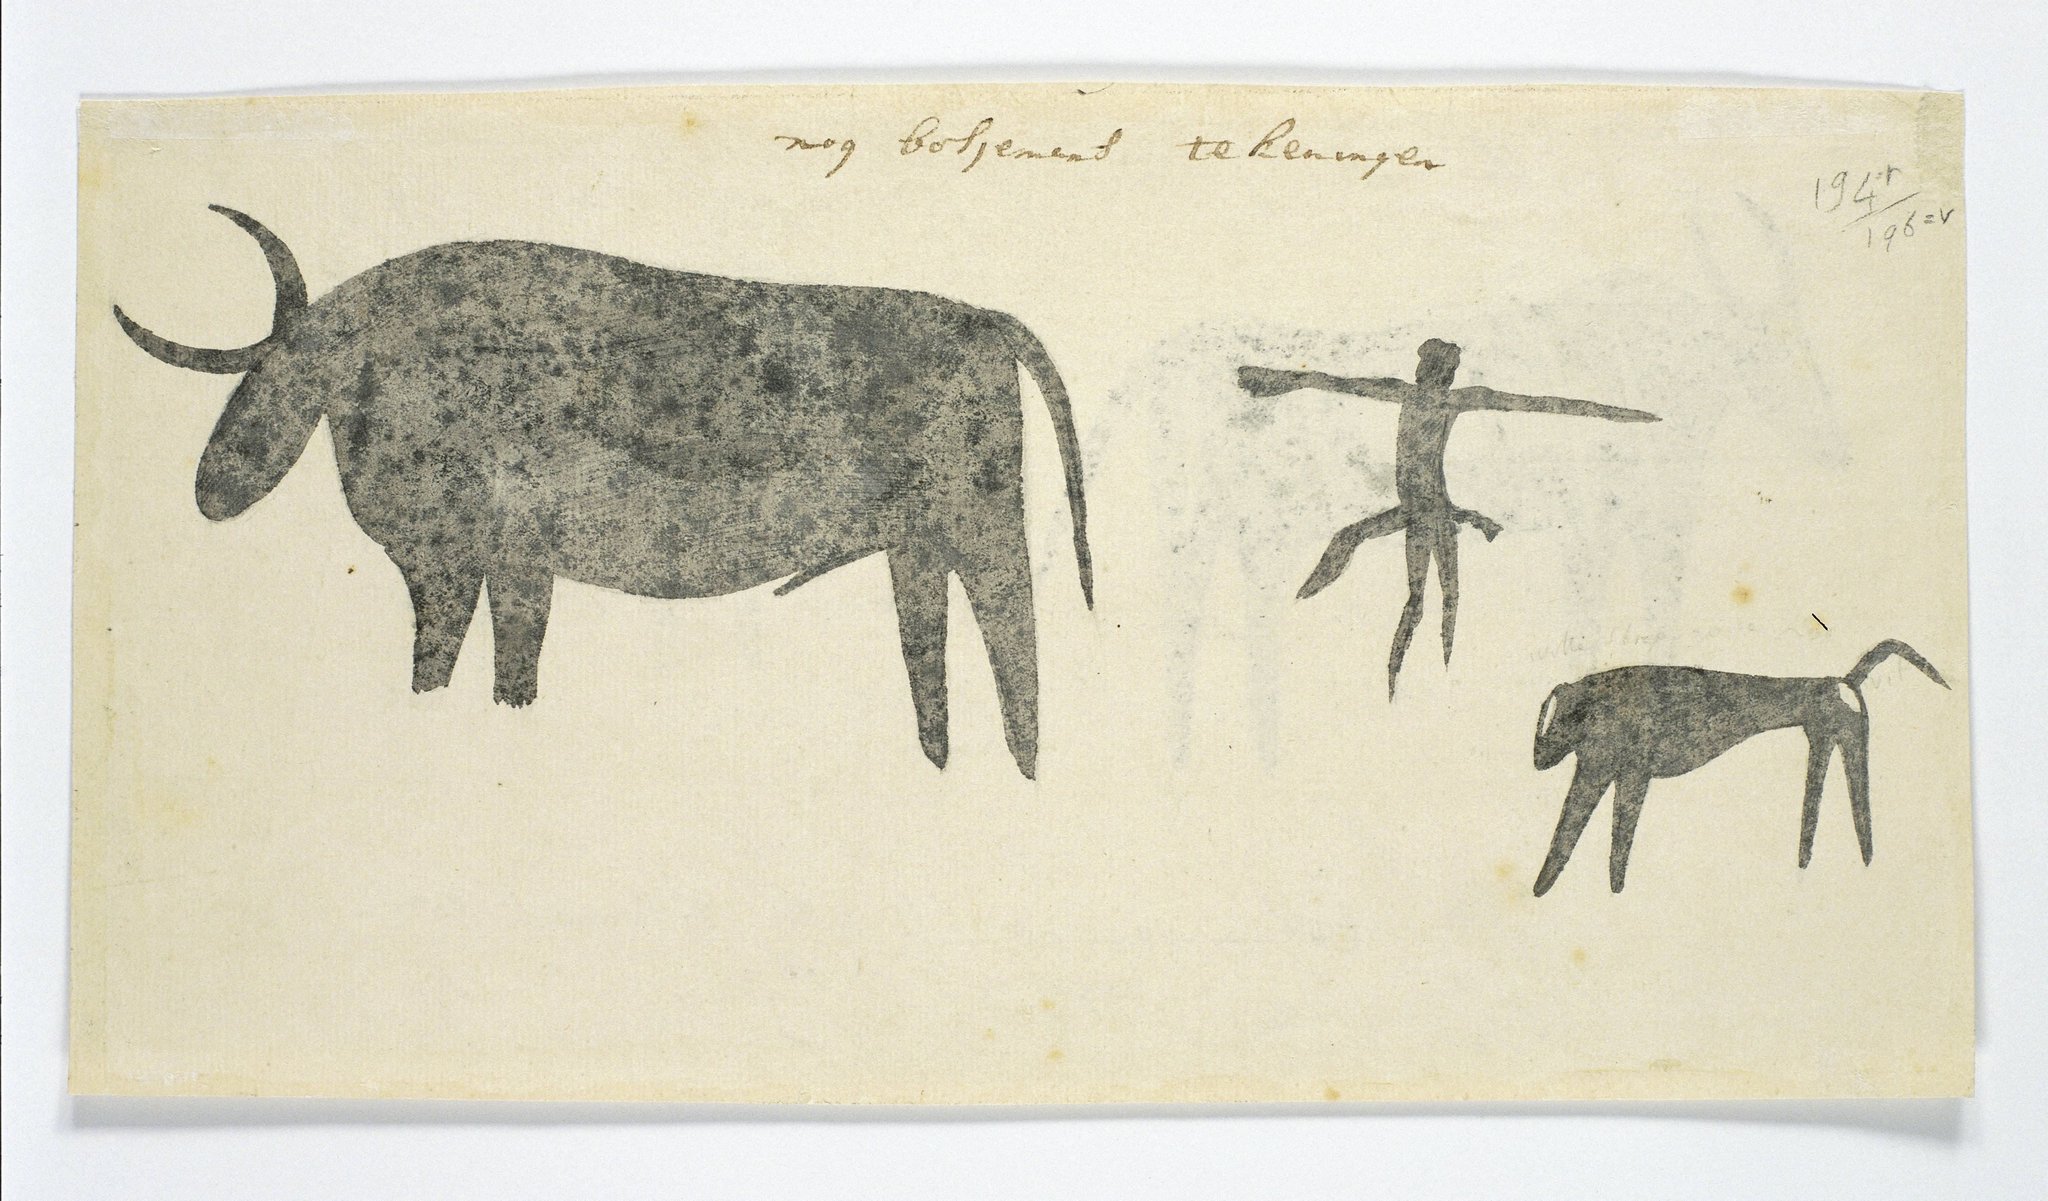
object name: drawing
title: Copies after San rock-paintings of an ox, a baboon, and a man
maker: robert jacob gordon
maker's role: draughtsman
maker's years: 1743-1795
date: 1777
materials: chalk, ink, paper, pencil, watercolor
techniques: brush, pen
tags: zuid-afrika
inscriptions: annotation: ‘nog bosjesmans tekeningen’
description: Twee dieren, een grote os of buffel en een kleiner hondachtig dier, met een springend of dansend figuurtje. Rotstekening van de San, die achter de Sneeuwberg (Noa Gore) wonen.